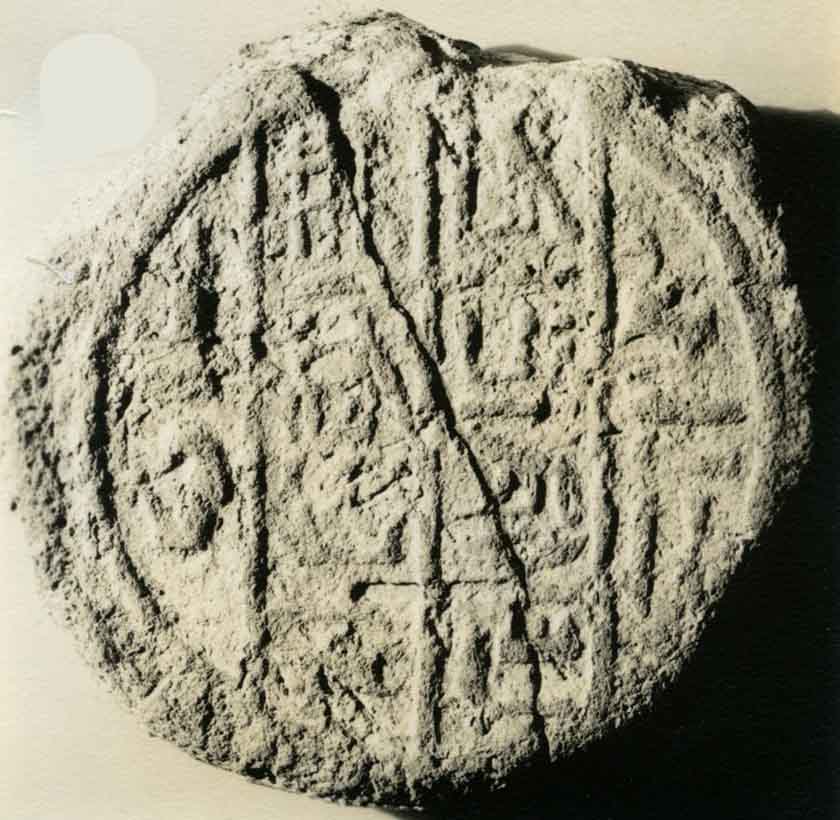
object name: cone, tjata, circular impression, festival leader of amun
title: Funerary Cone of the Festival Leader of Amun Tjata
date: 1550-1295 BCE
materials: pottery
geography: egypt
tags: hieroglyphs